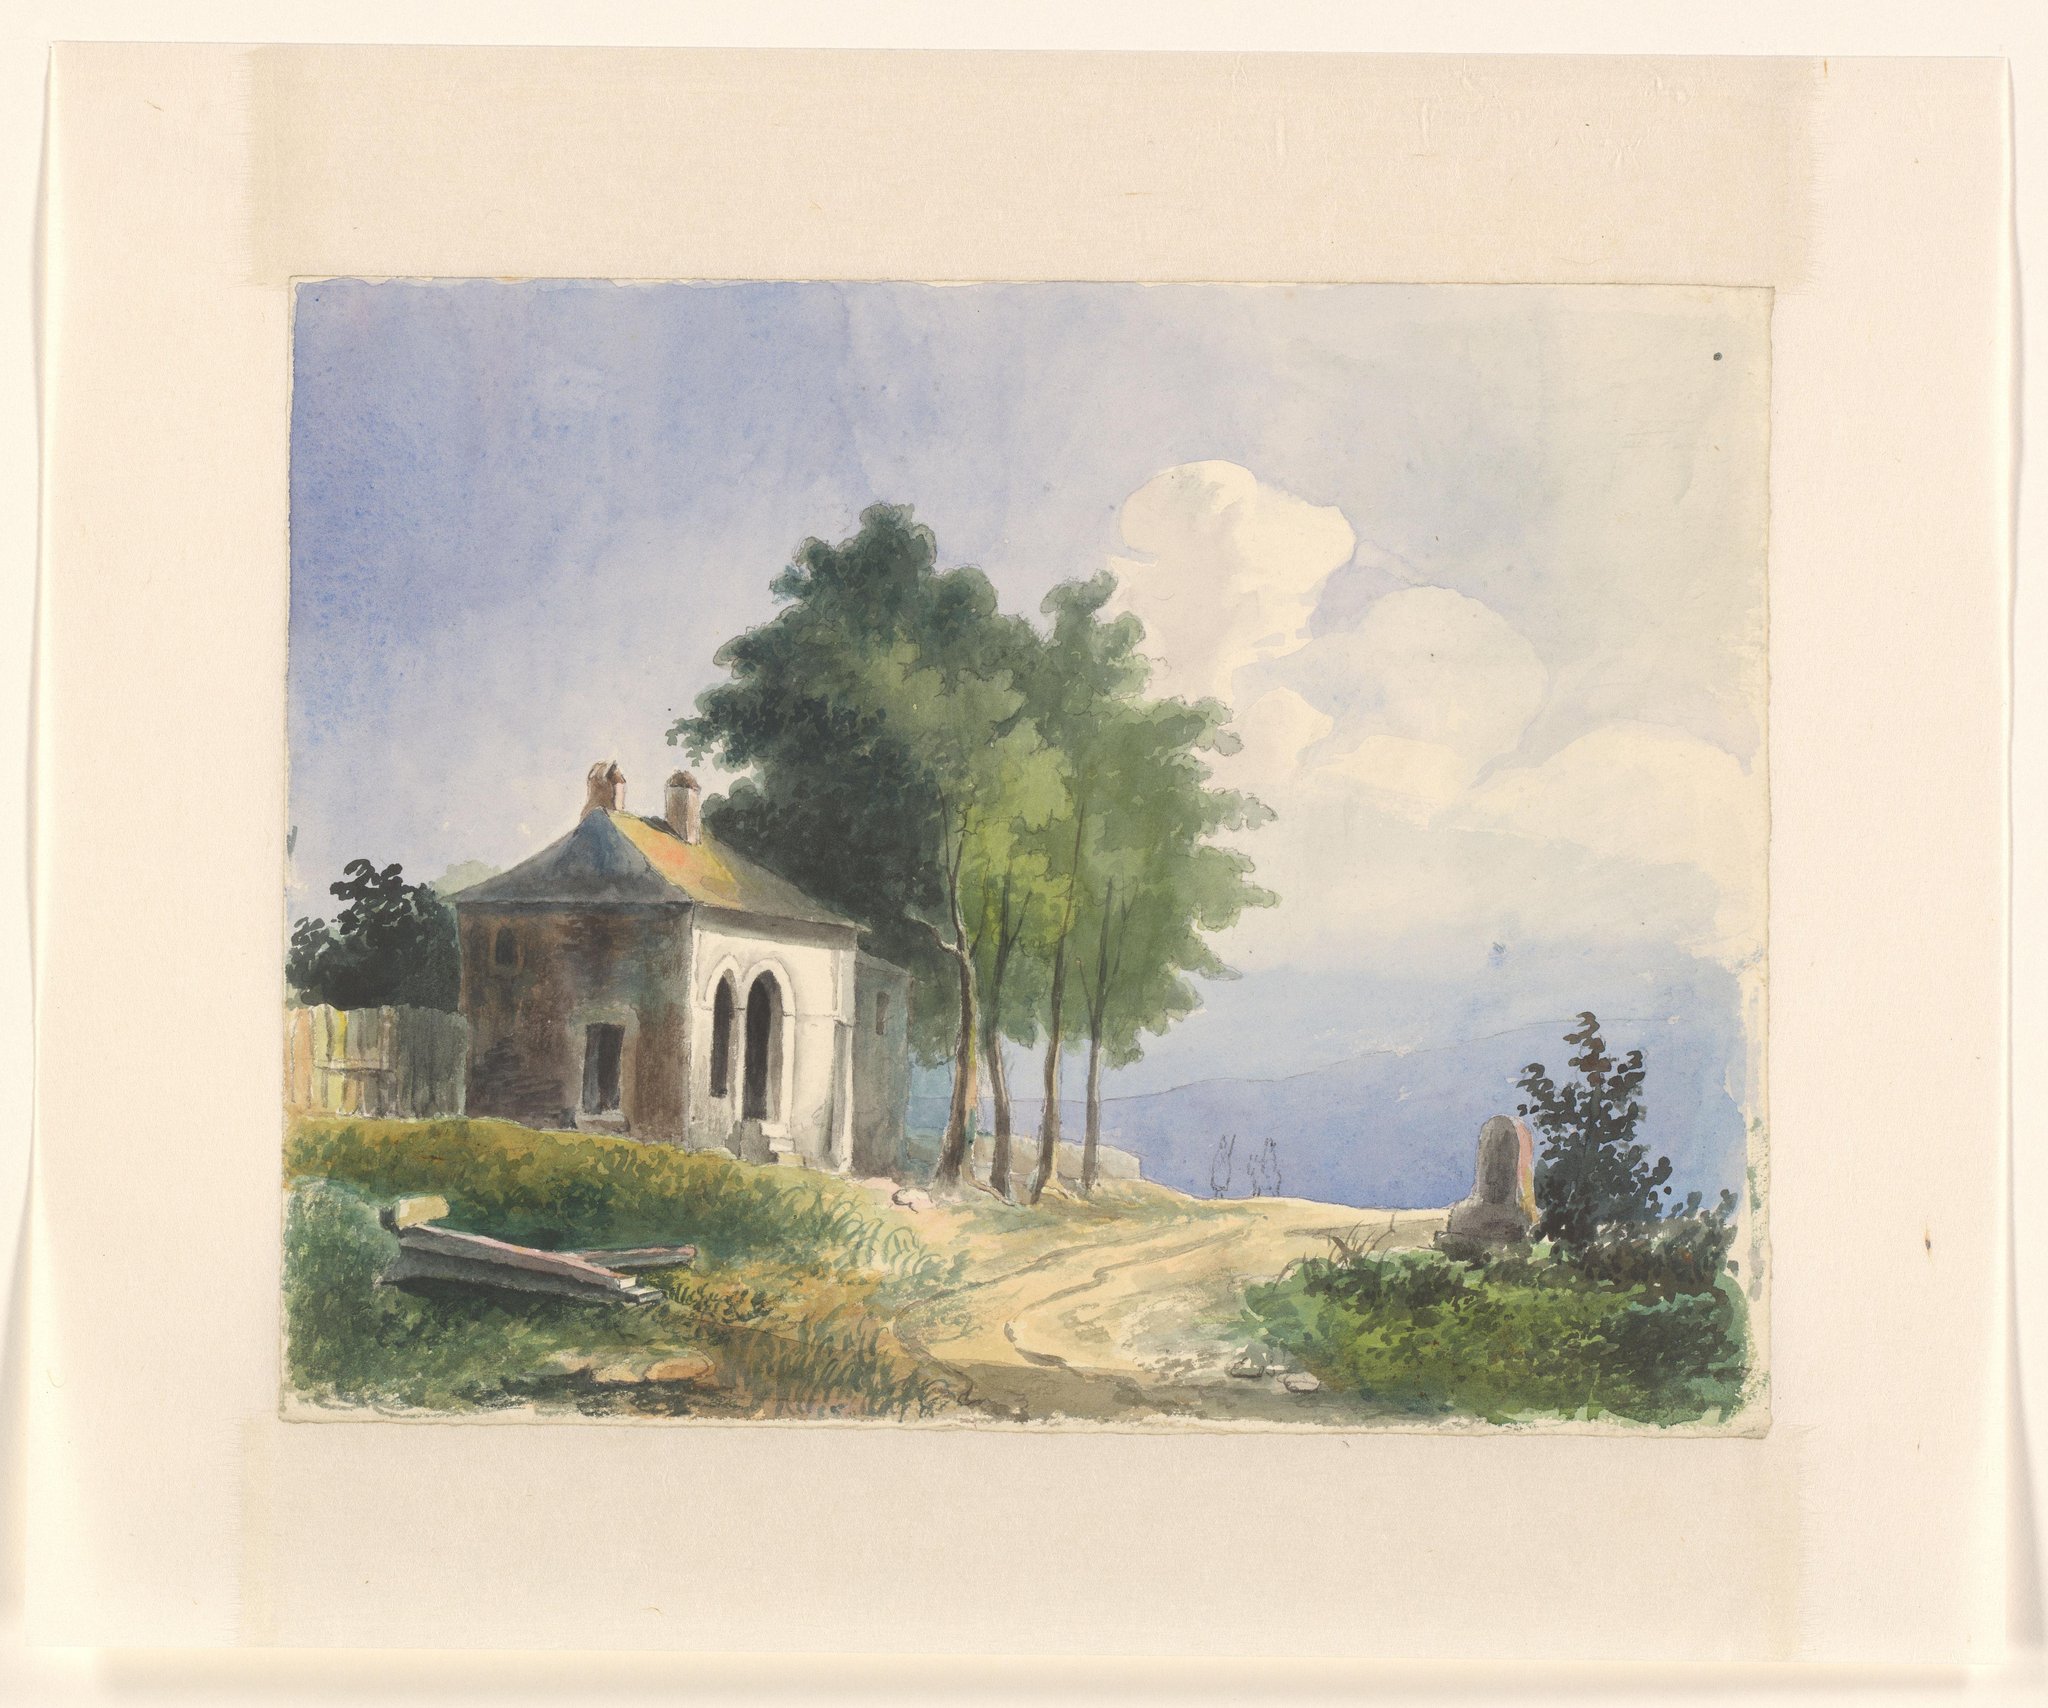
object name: drawing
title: Landschap met een gebouw en grenspaal langs een weg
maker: johannes van reijn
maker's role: draughtsman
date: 1800-1900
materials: paper, watercolor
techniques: brush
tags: road, path, mountains